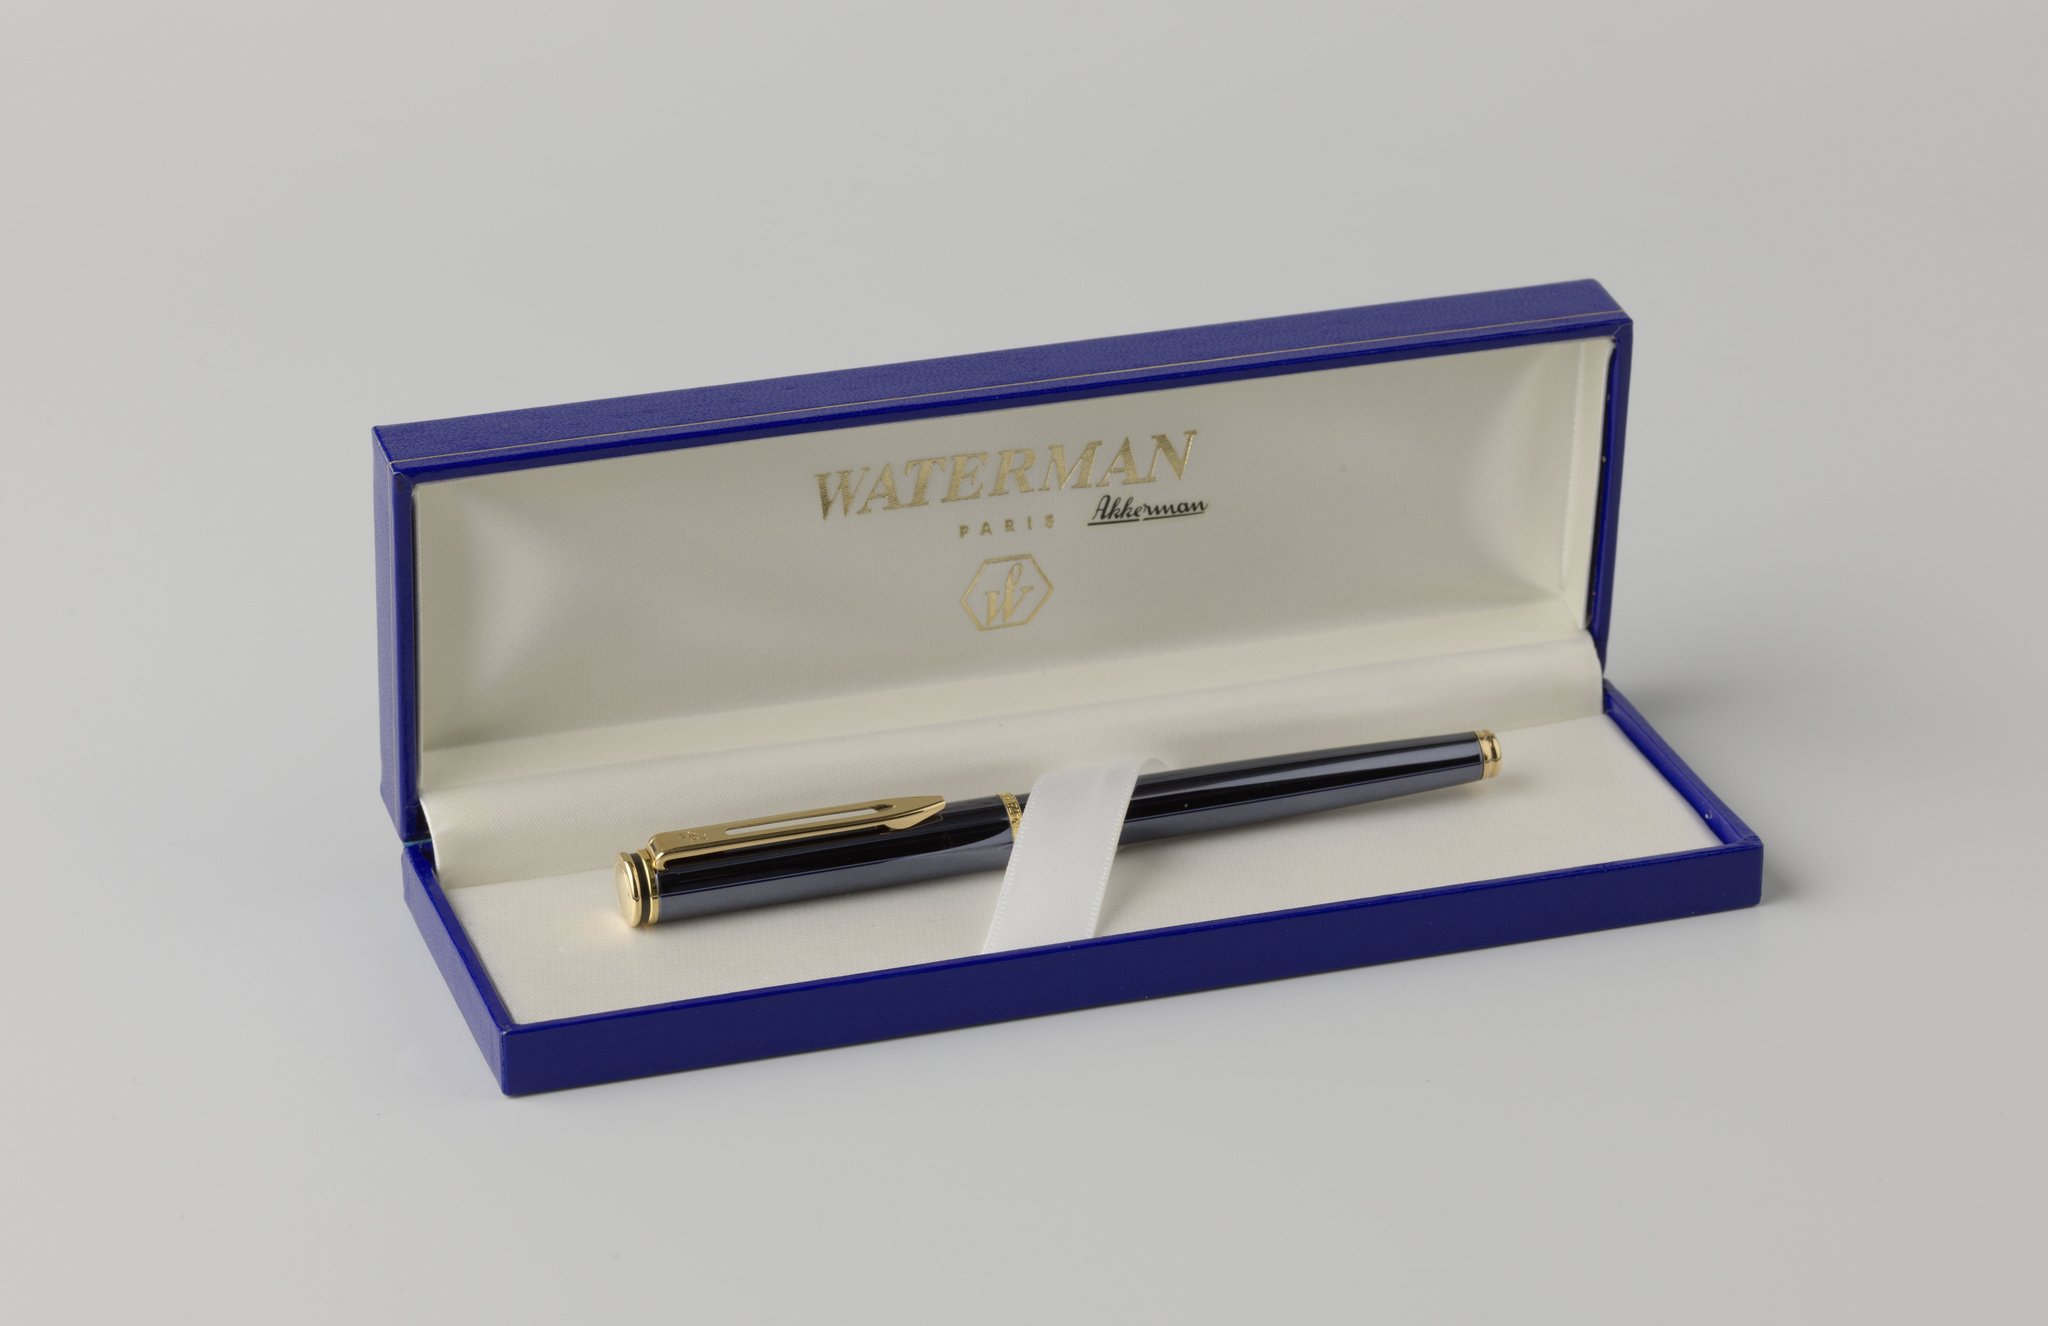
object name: pen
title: Pen gebruikt bij het ondertekenen van de protocollen van overdracht bij de verzelfstandiging van het Rijksmuseum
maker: waterman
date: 1995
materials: alloy, cardboard, plastic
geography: france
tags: rijksmuseum amsterdam, amsterdam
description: Blauwgrijze rollerpen met goudkleurige randen aan het uiteinde, langs de vulling en de dop. Goudkleurige clip; zwarte vulling.